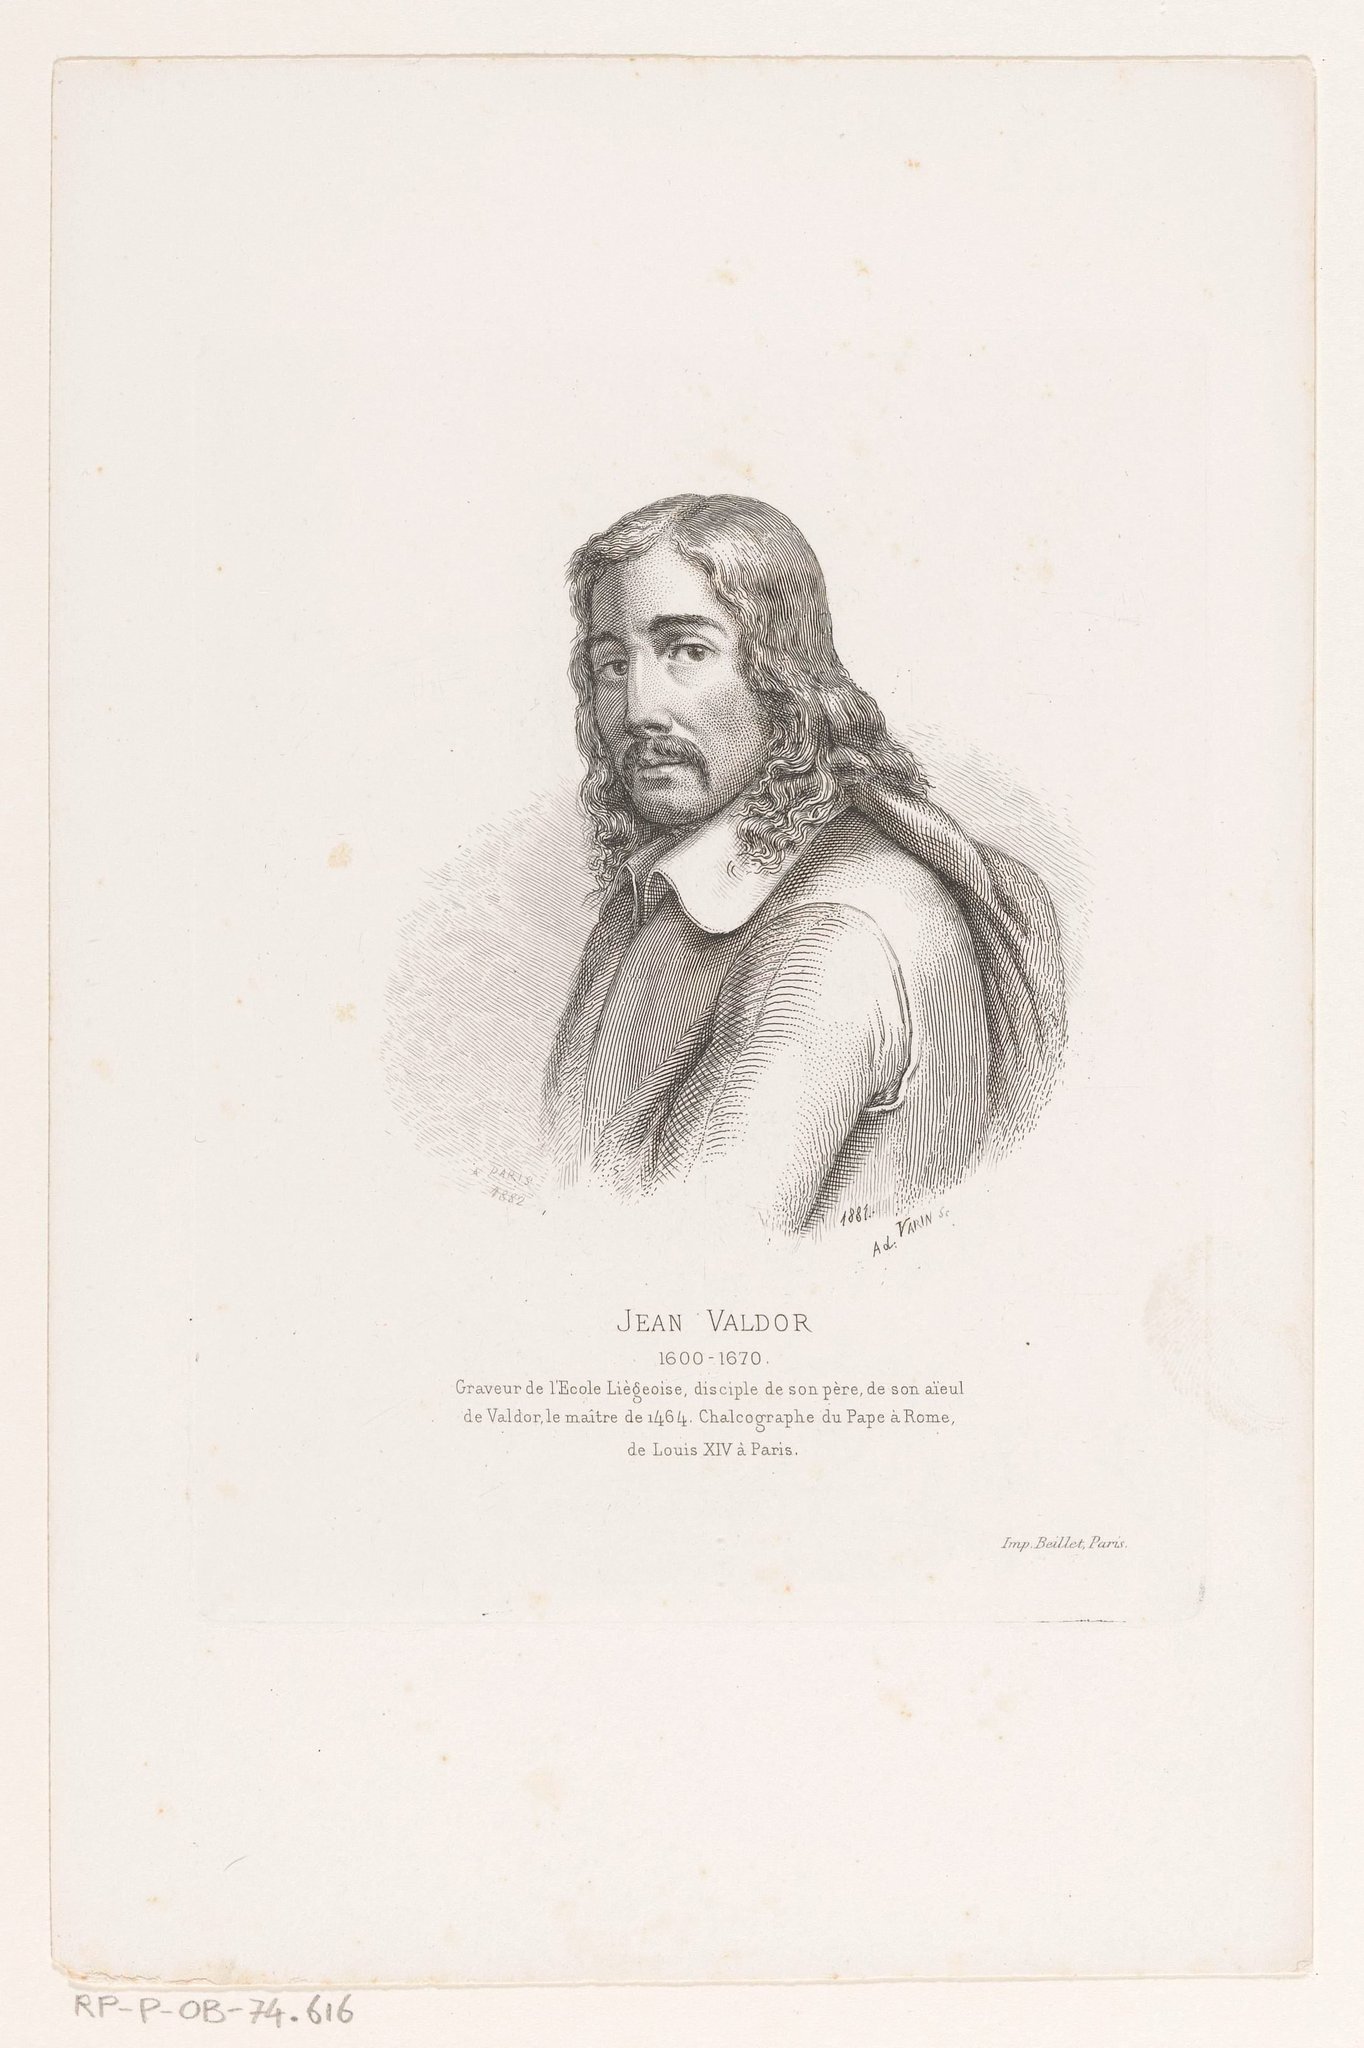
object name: print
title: Jean Valdor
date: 1881-1882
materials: paper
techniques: engraving, etching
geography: paris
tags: liège, paris, johannes valdor (ii), historical persons, portrait, self-portrait of artist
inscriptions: collector's mark: Lugt 2228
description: Prent uit: École liégeoise. Les Graveurs. Leurs portraits, reproduits au burin, d'après les originaux, par Adolphe Varin, 1366-1850. Avec notes historiques (...). Parijs: Fr. Gobbaerts, ca. 1684.